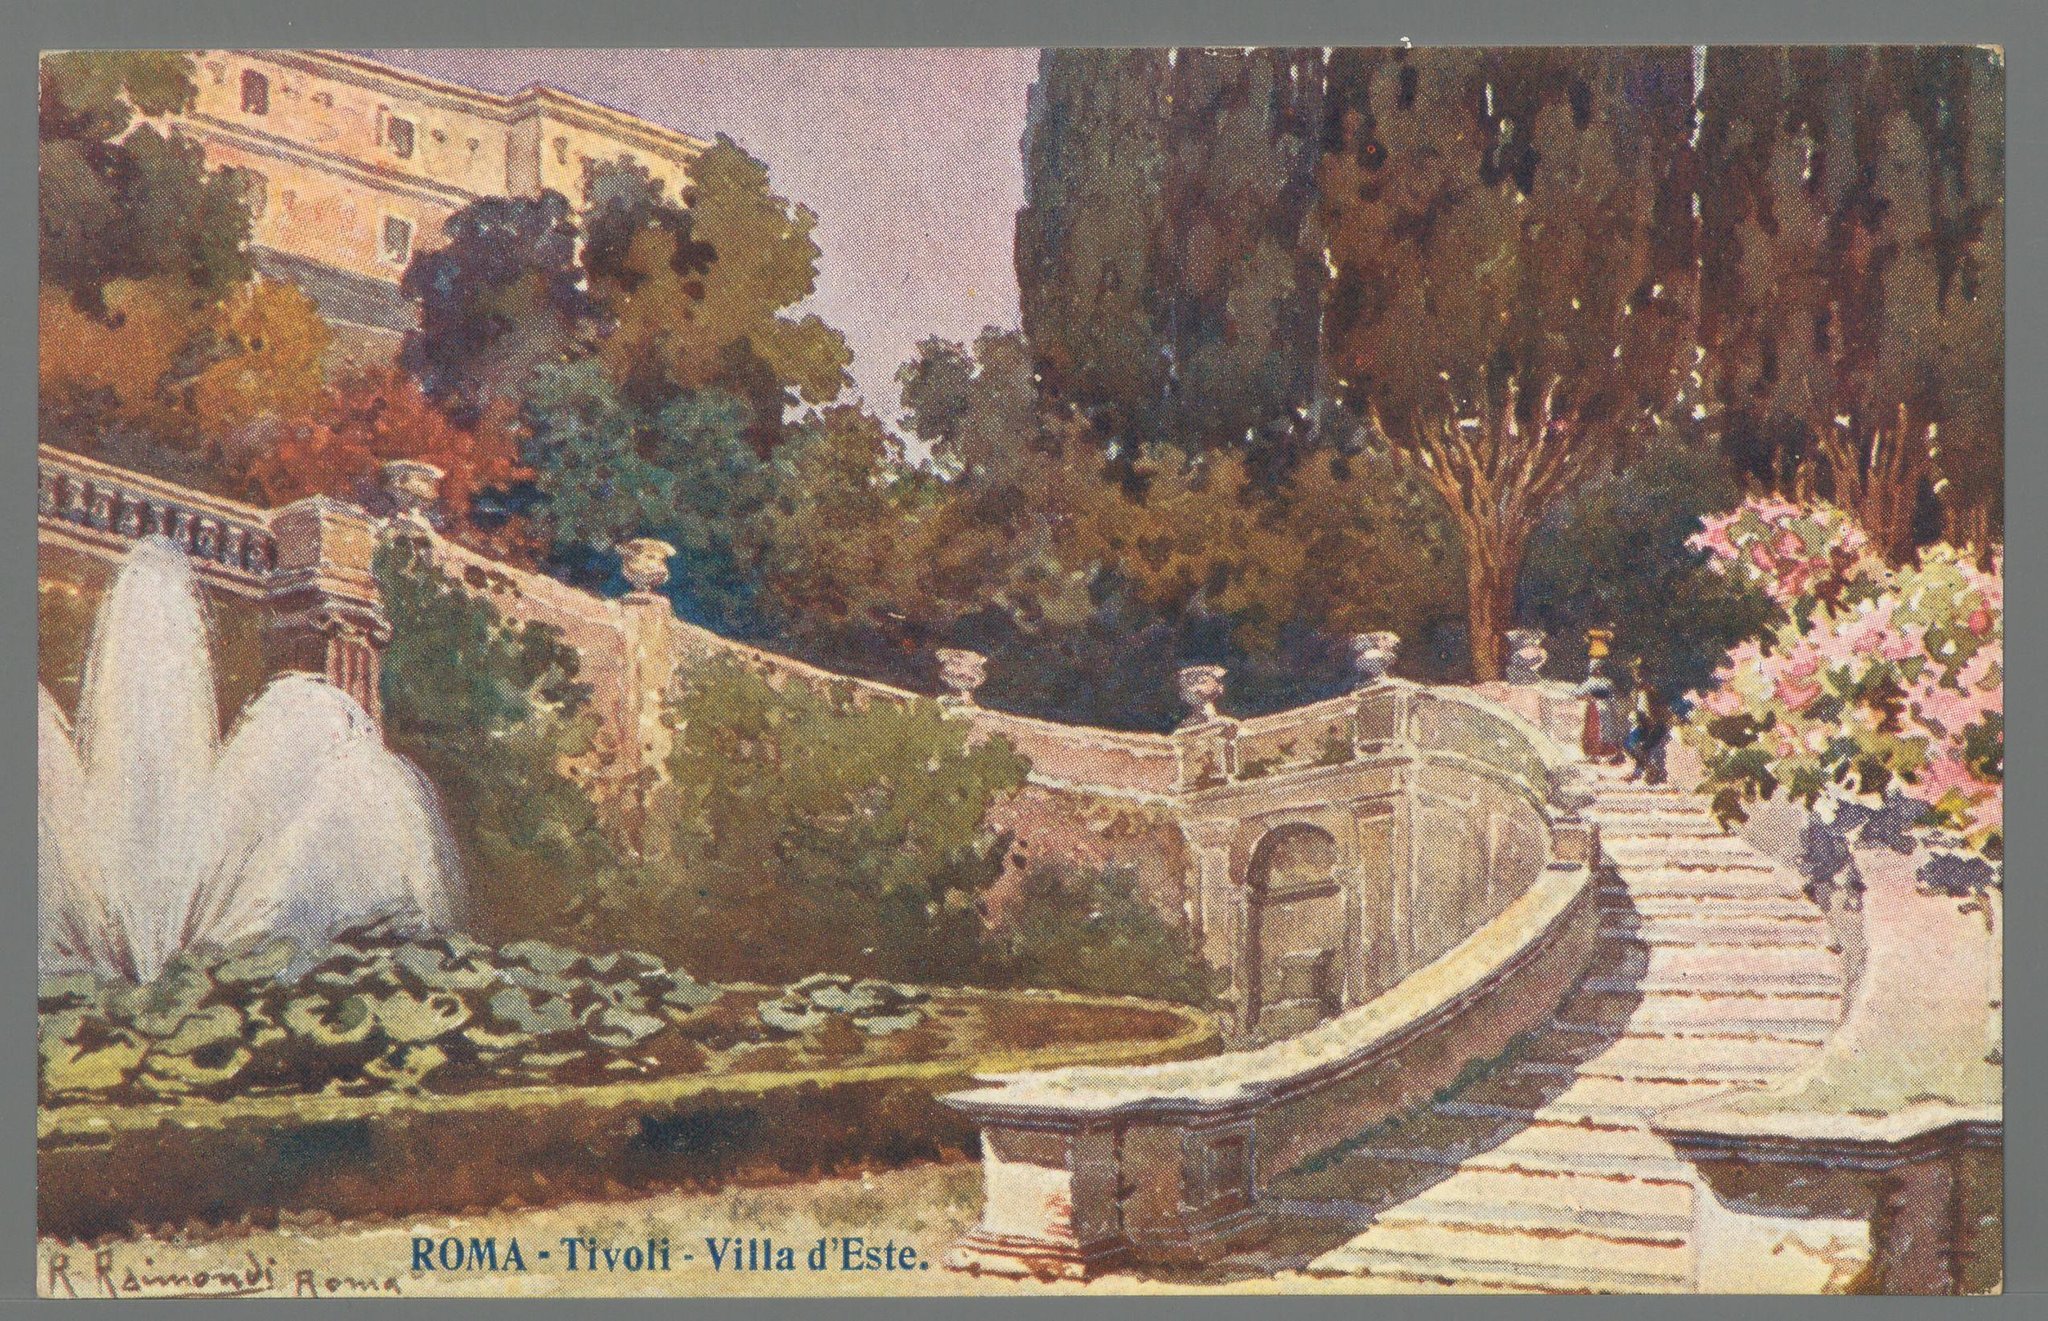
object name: ansichtkaart, prentbriefkaart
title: Roma. Tivoli. Villa D'Este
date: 1906-1930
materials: cardboard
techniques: three-color autotype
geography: rome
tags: garden, garden fountain, villa